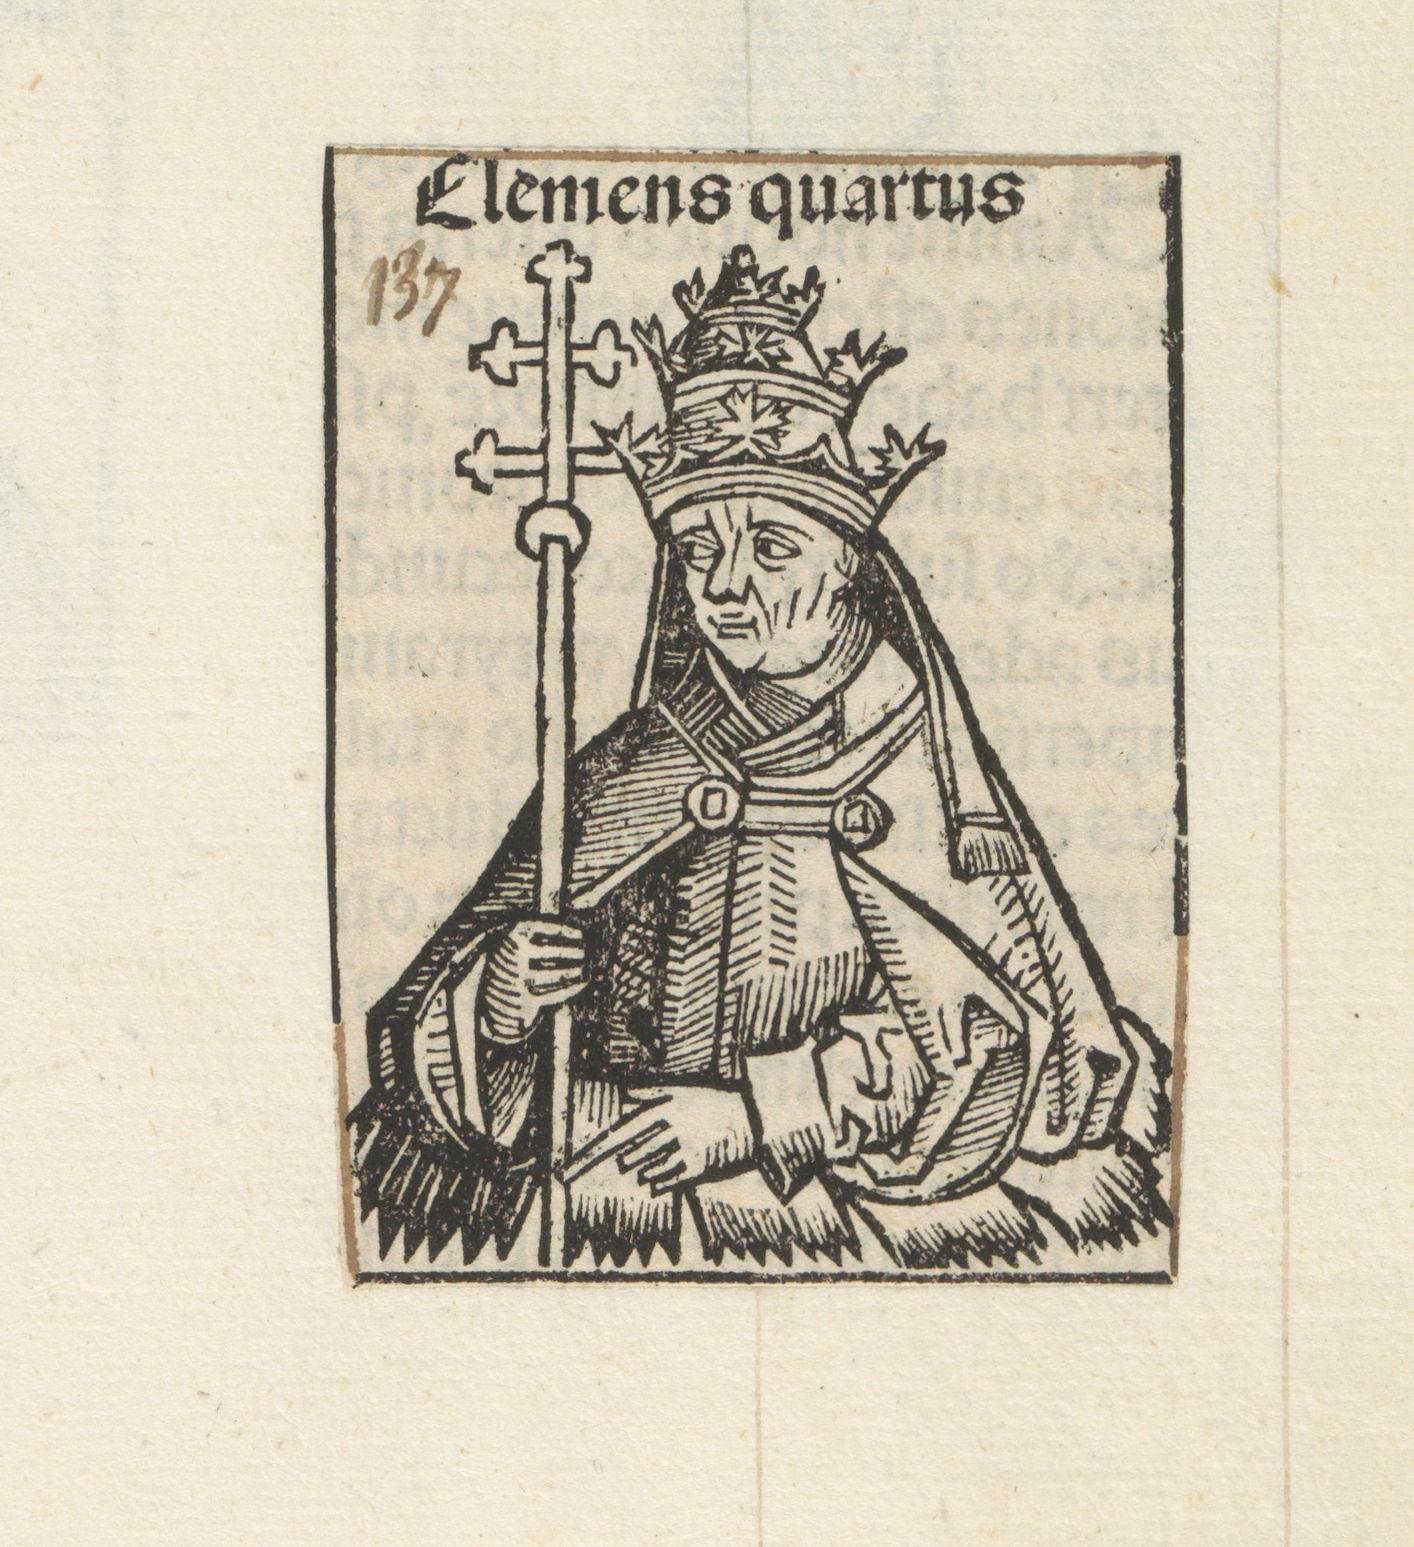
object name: album leaf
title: Clemens quartus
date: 1493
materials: paper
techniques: letterpress printing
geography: nuremberg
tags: pope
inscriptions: inscription: ‘137’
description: Een bloemkelk met een paus. Hij draagt een tiara en heeft een staf met dubbel kruis in zijn handen. De voorstelling is onderdeel van de opeenvolging pausen in de Liber Chronicarum. De tekst identificeert de man als Clemens IV. De prent maakt deel uit van een album.